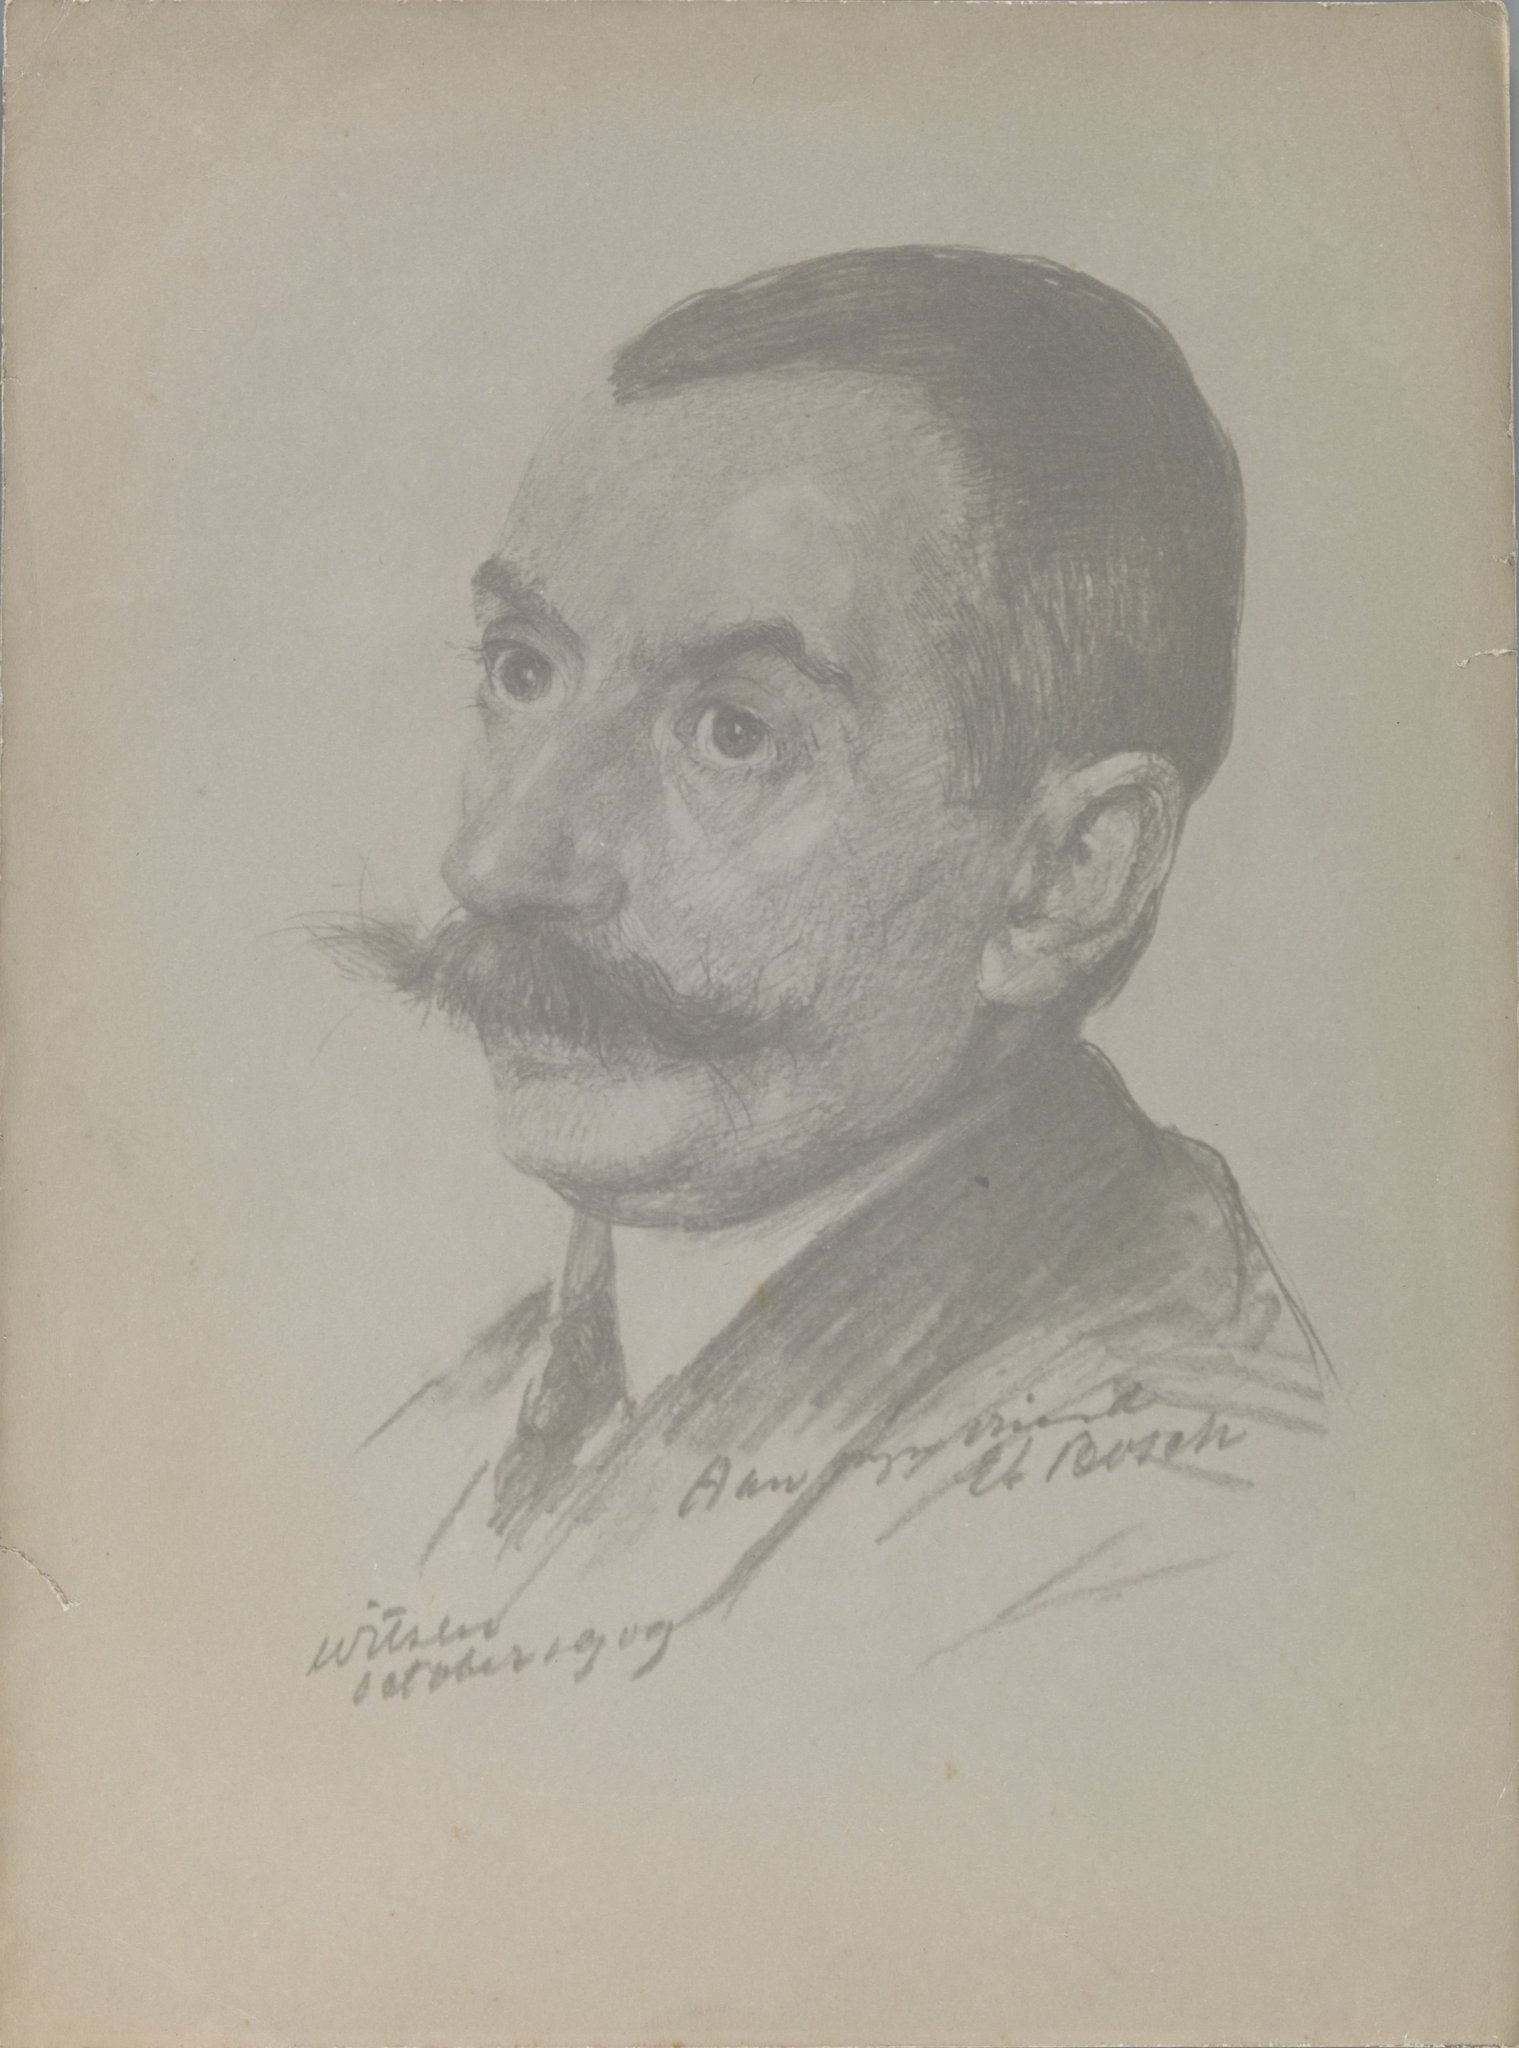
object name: photograph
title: Reproductie naar een foto, schilderij, tekening of prent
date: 1860-1915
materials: paper, photographic support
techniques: gelatin silver print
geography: netherlands